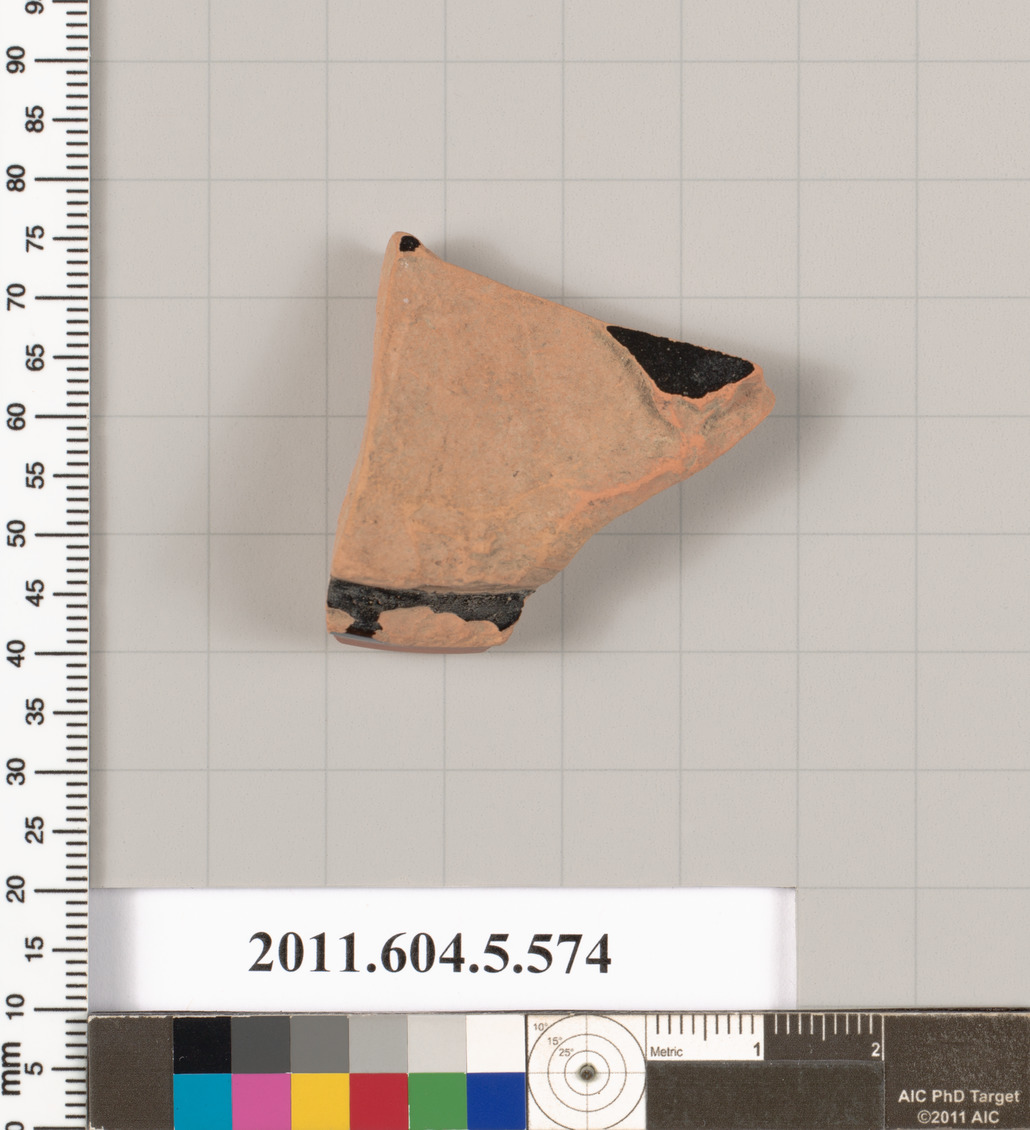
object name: stemless kylix fragment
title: Terracotta fragment of a stemless kylix (drinking cup)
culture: greek, attic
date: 600-401 BCE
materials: terracotta